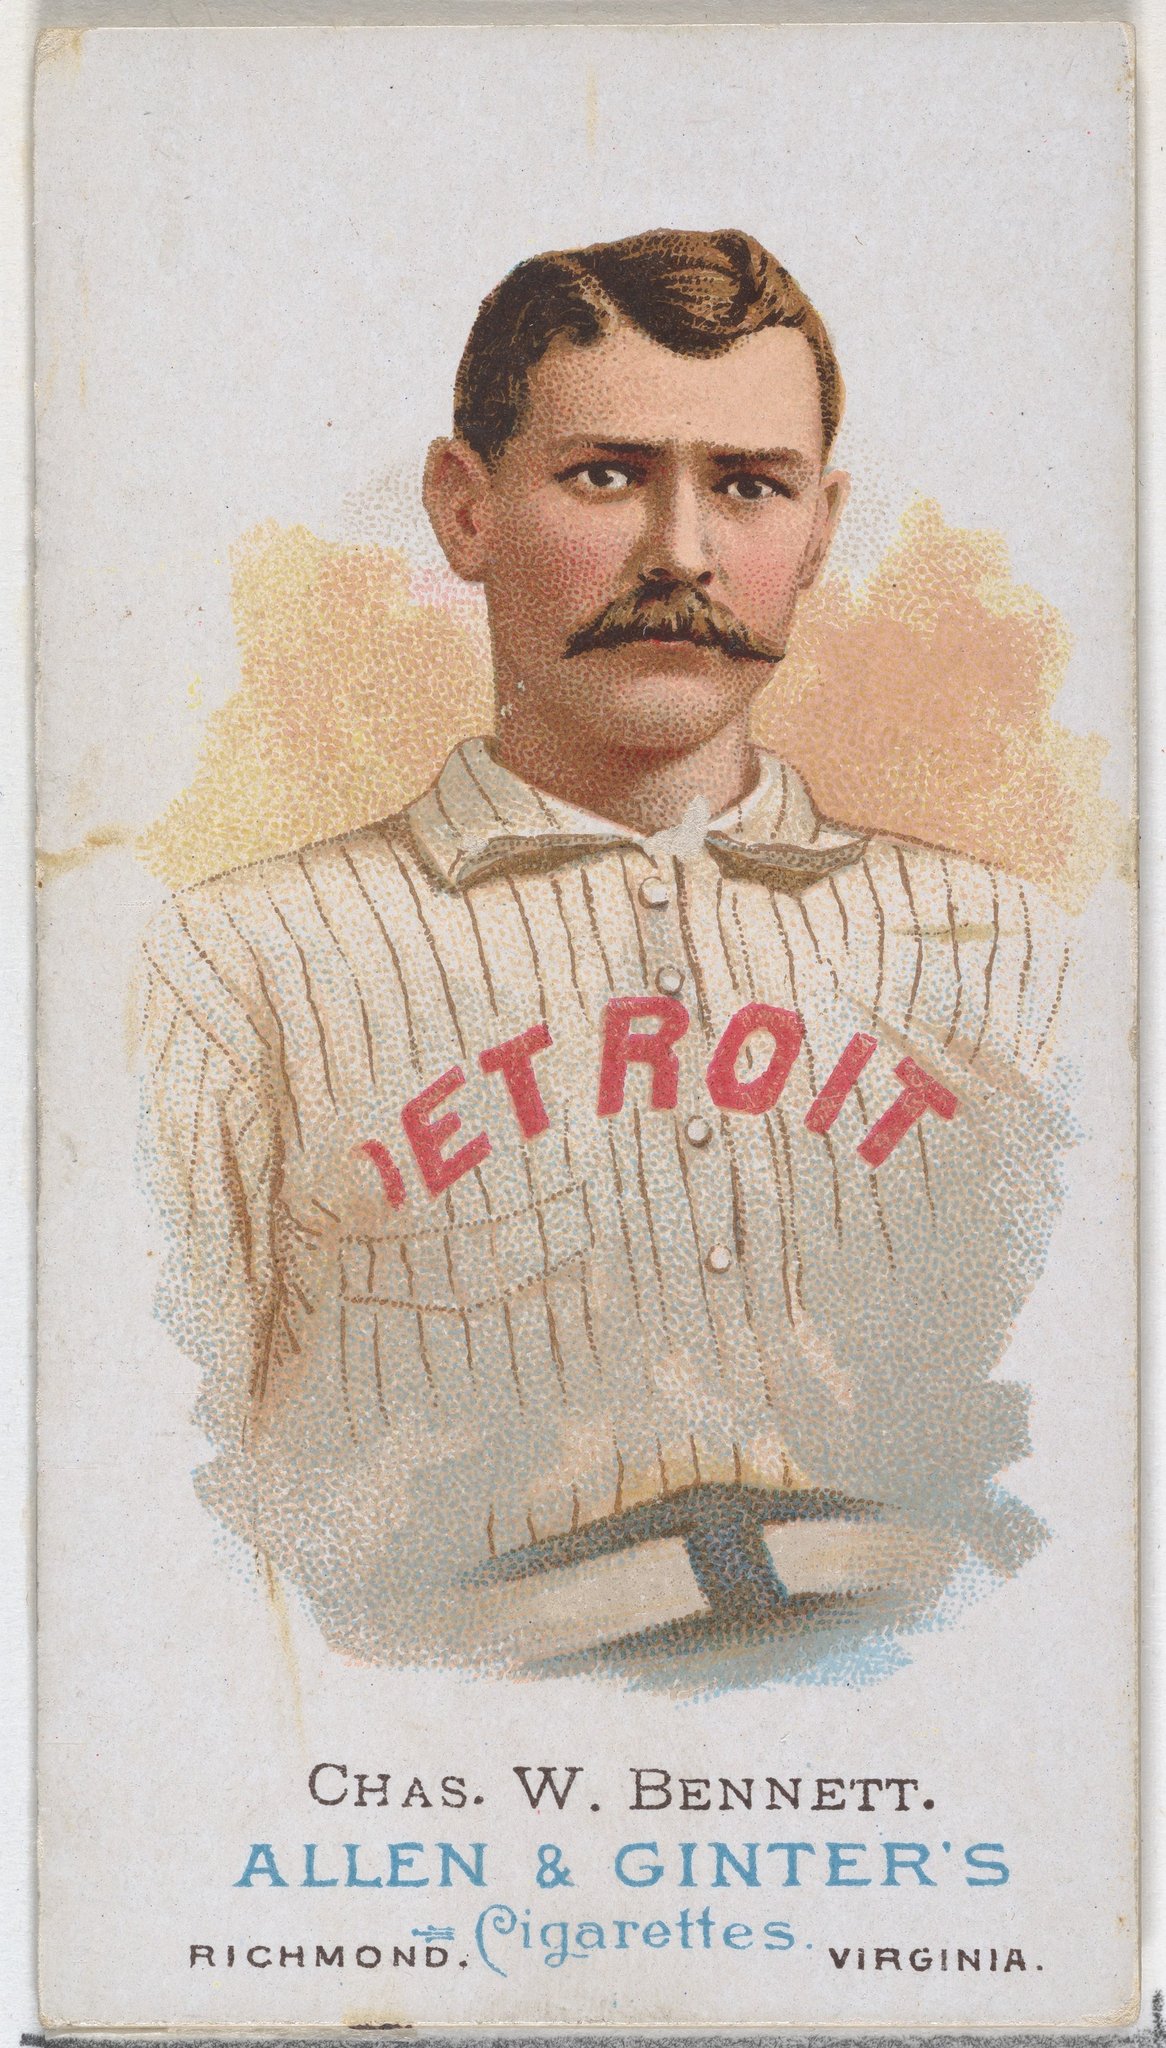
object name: baseball card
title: Charles W. Bennett, Baseball Player, from World's Champions, Series 1 (N28) for Allen & Ginter Cigarettes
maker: allen & ginter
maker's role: publisher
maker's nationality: american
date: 1887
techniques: color lithograph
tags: men,portraits,baseball,athletes